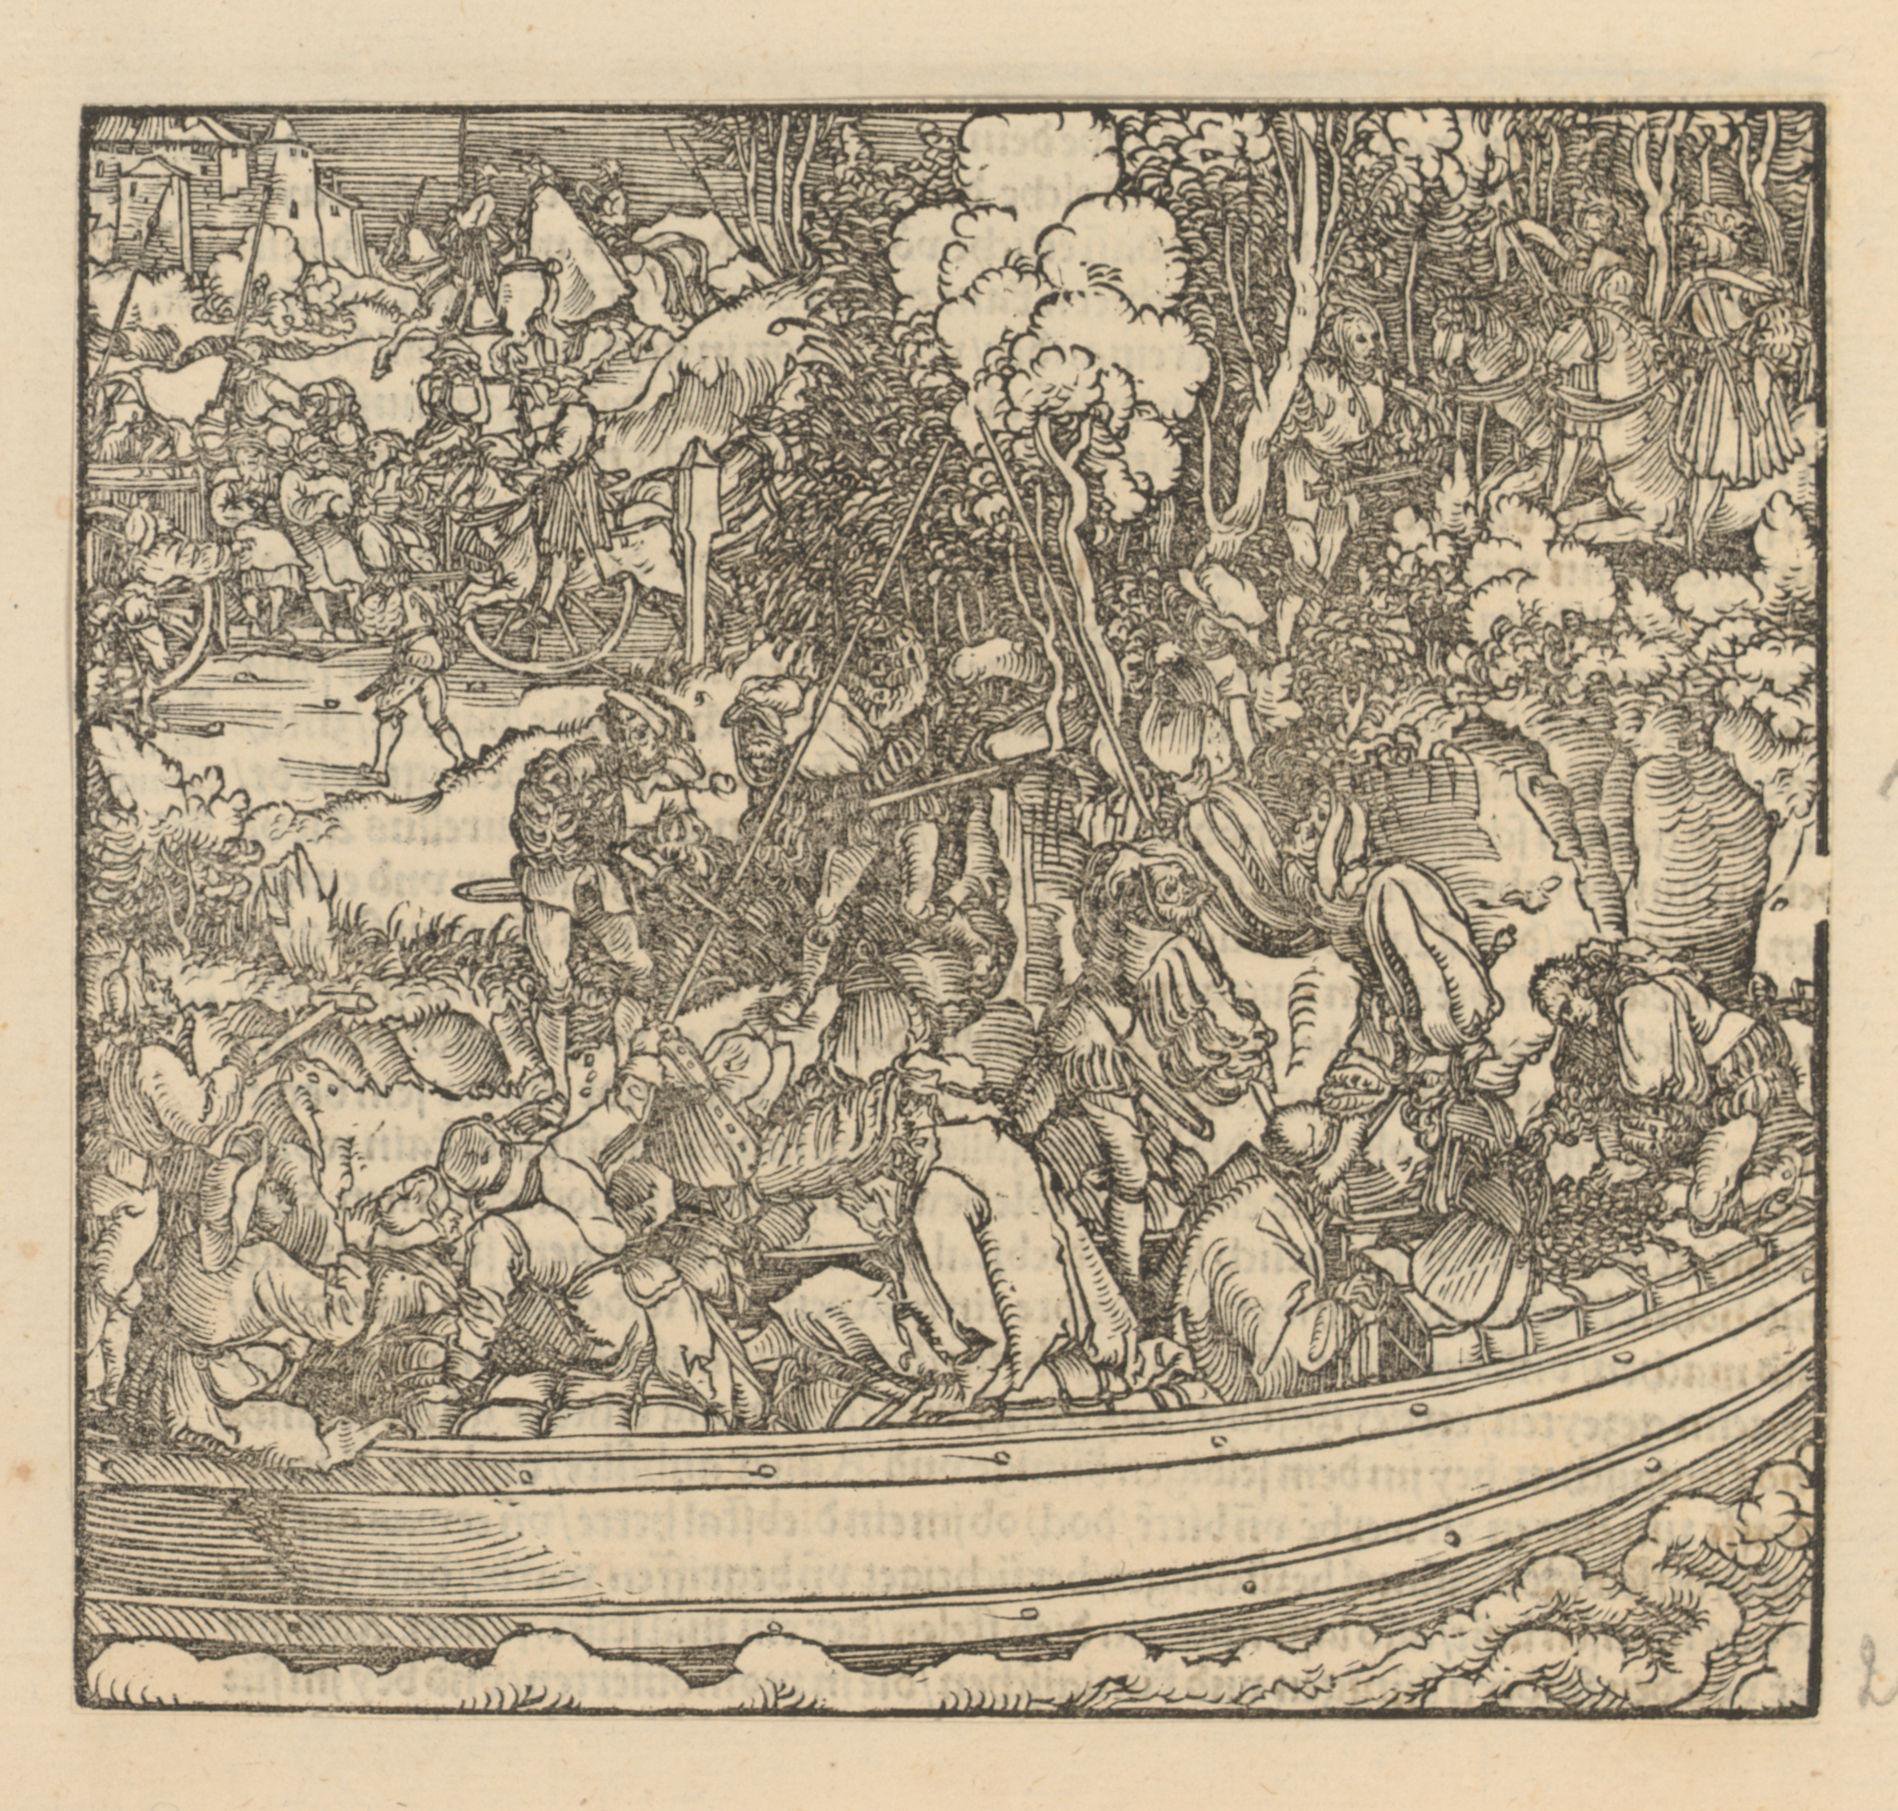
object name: print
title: Rovers vluchten weg in een boot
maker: Anonymous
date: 1514-1532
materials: paper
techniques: letterpress printing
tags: escape, escape attempts, robber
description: Deze prent is gebruikt in: Petrarca, Francesco. Von der Artzney bayder Glück, des guten und widerwertigen: unnd weß sich ain yeder inn Gelück und Unglück halten sol (...). Augsburg: Heinrich Steiner, 1532. Deze uitgave is ook bekend onder de titel 'Trostspiegel in Glück und Unglück'.